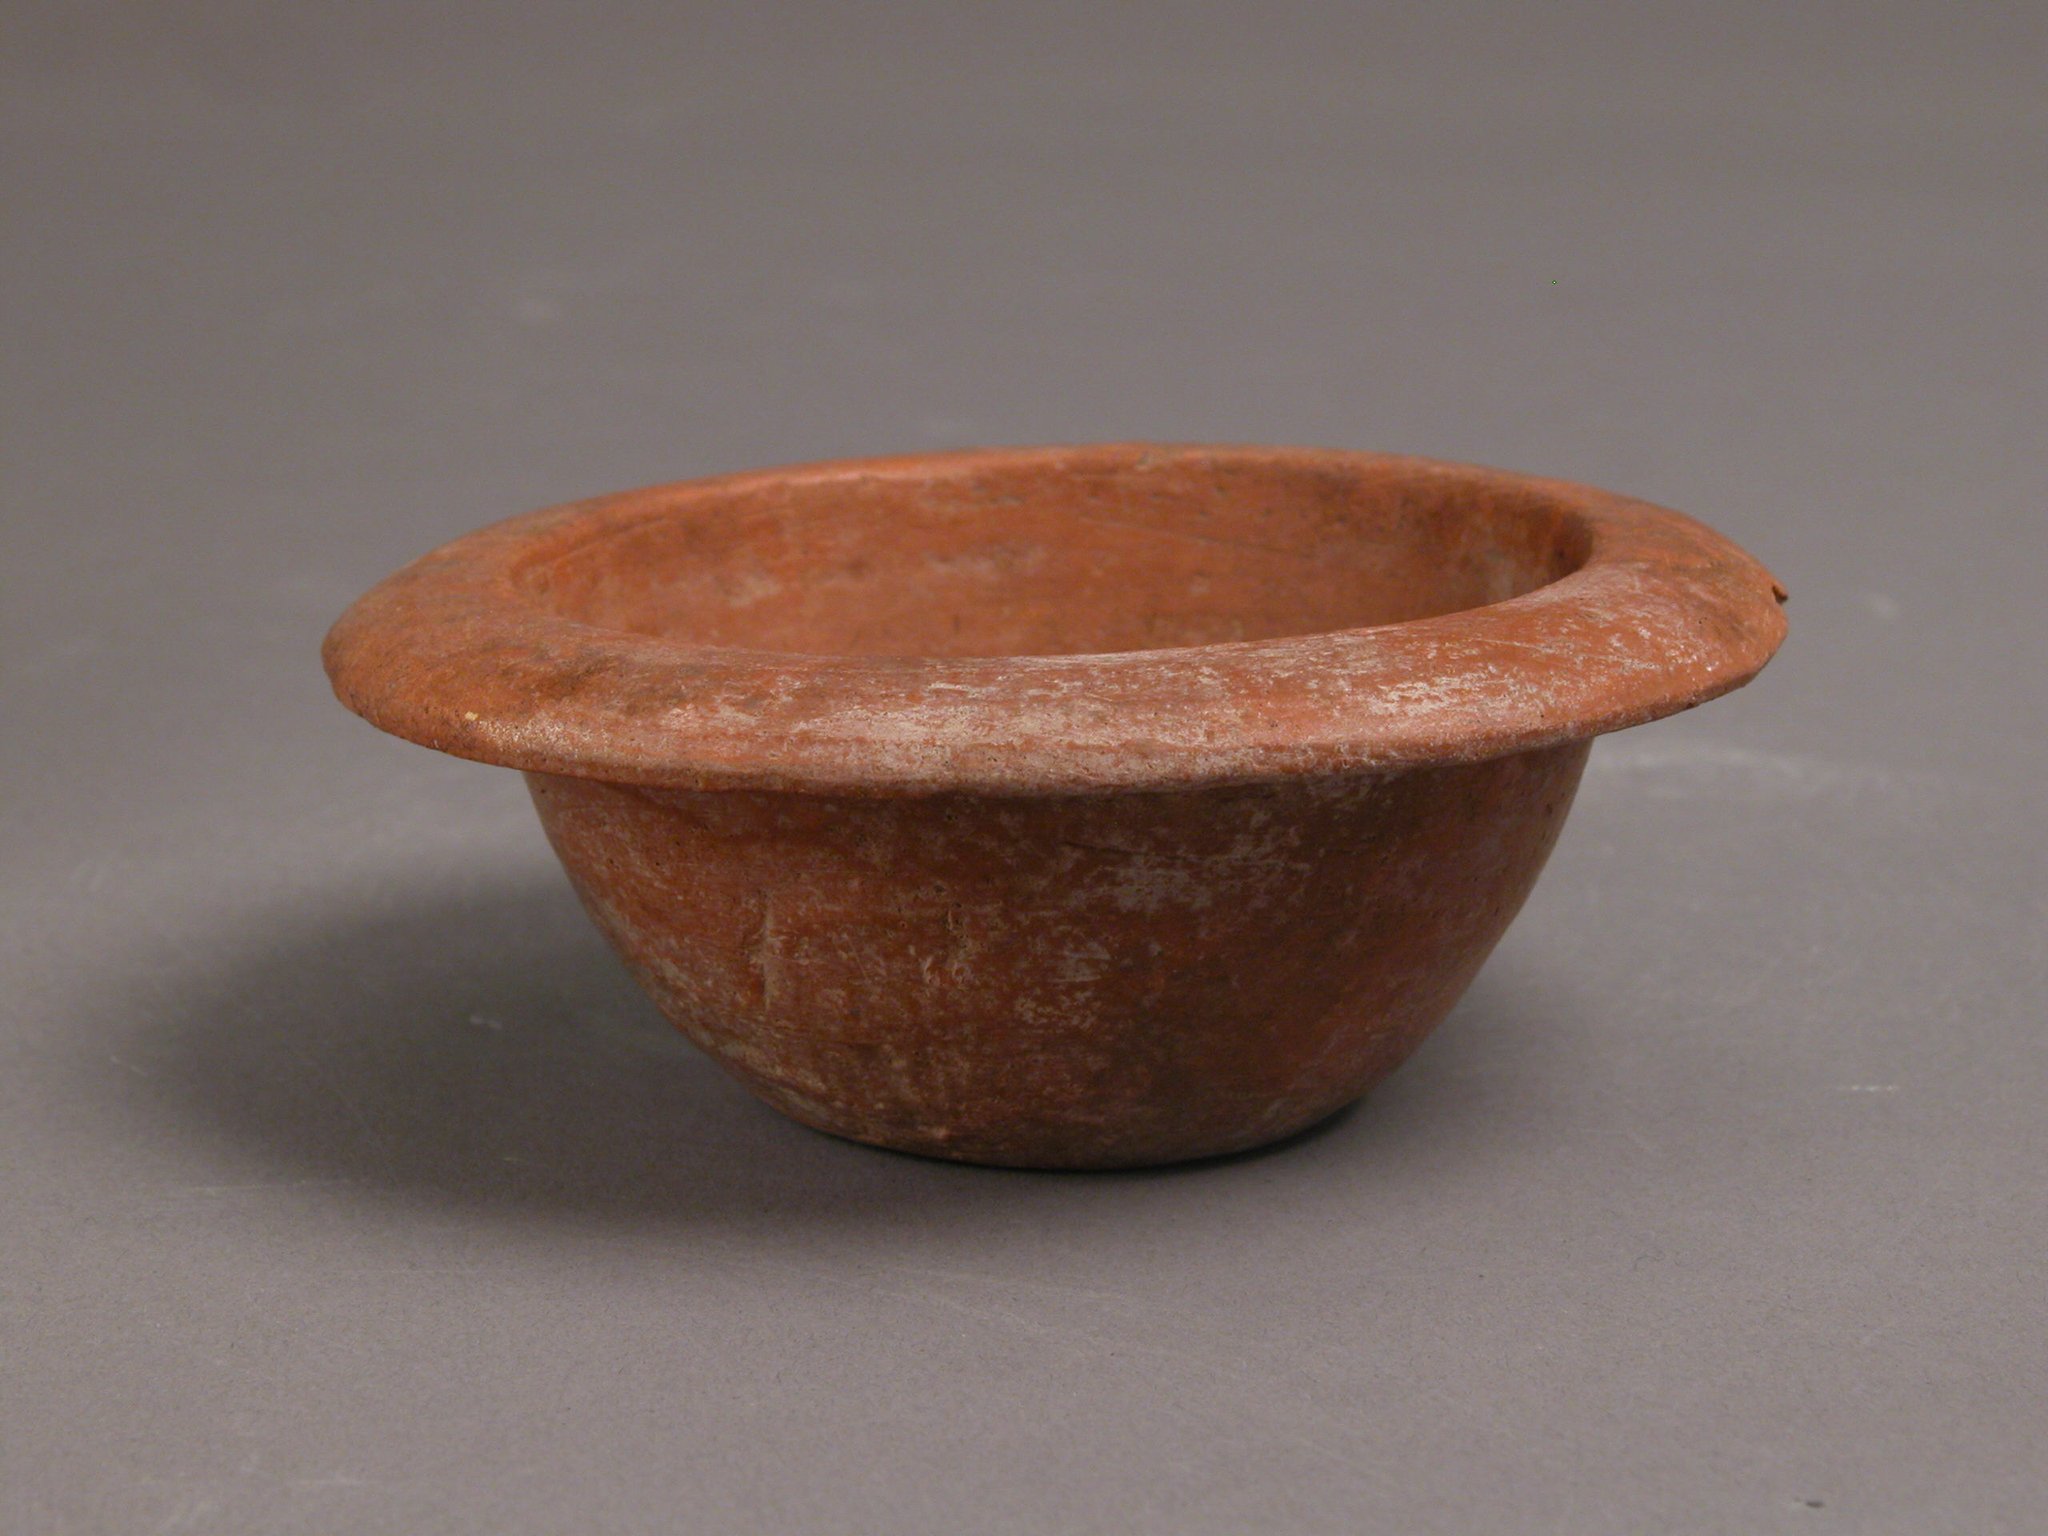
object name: bowl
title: Nesting Bowl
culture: coptic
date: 301-700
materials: earthenware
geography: egypt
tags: bowls